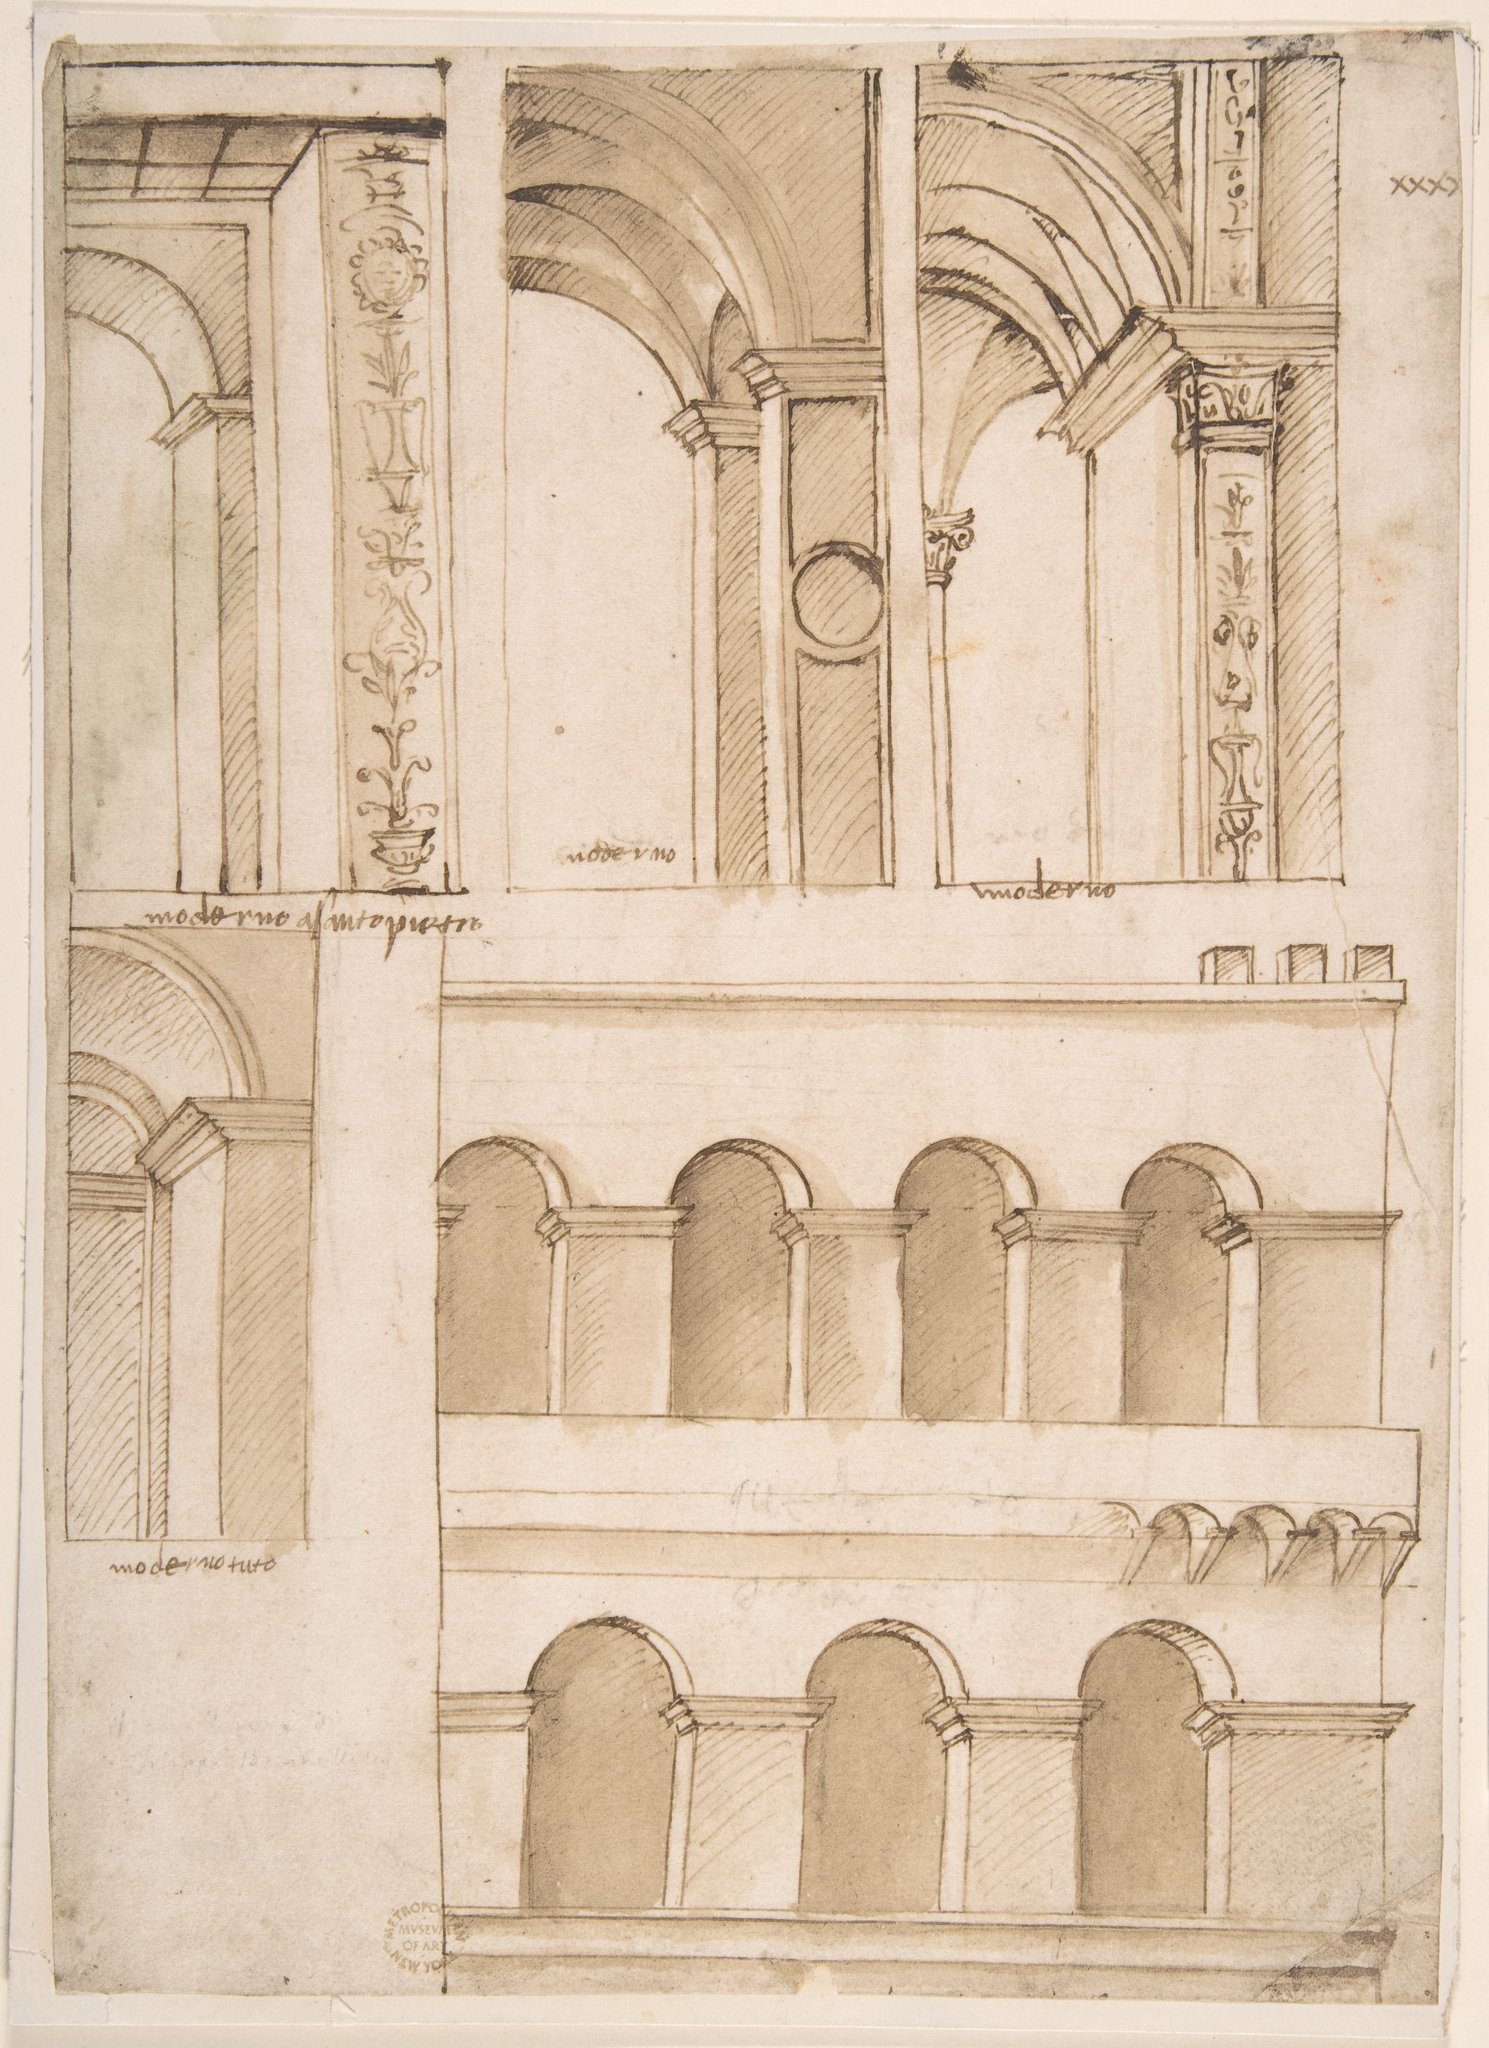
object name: drawing ornament architecture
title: Architecture Study containing Details of One or Several Buildings (possibly part of the street-facing architecture of old Saint Peter's Square in Rome)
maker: anonymous, italian, 16th century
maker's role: artist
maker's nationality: italian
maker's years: 1550-1600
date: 1490-1510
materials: ink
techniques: pen, wash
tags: architecture